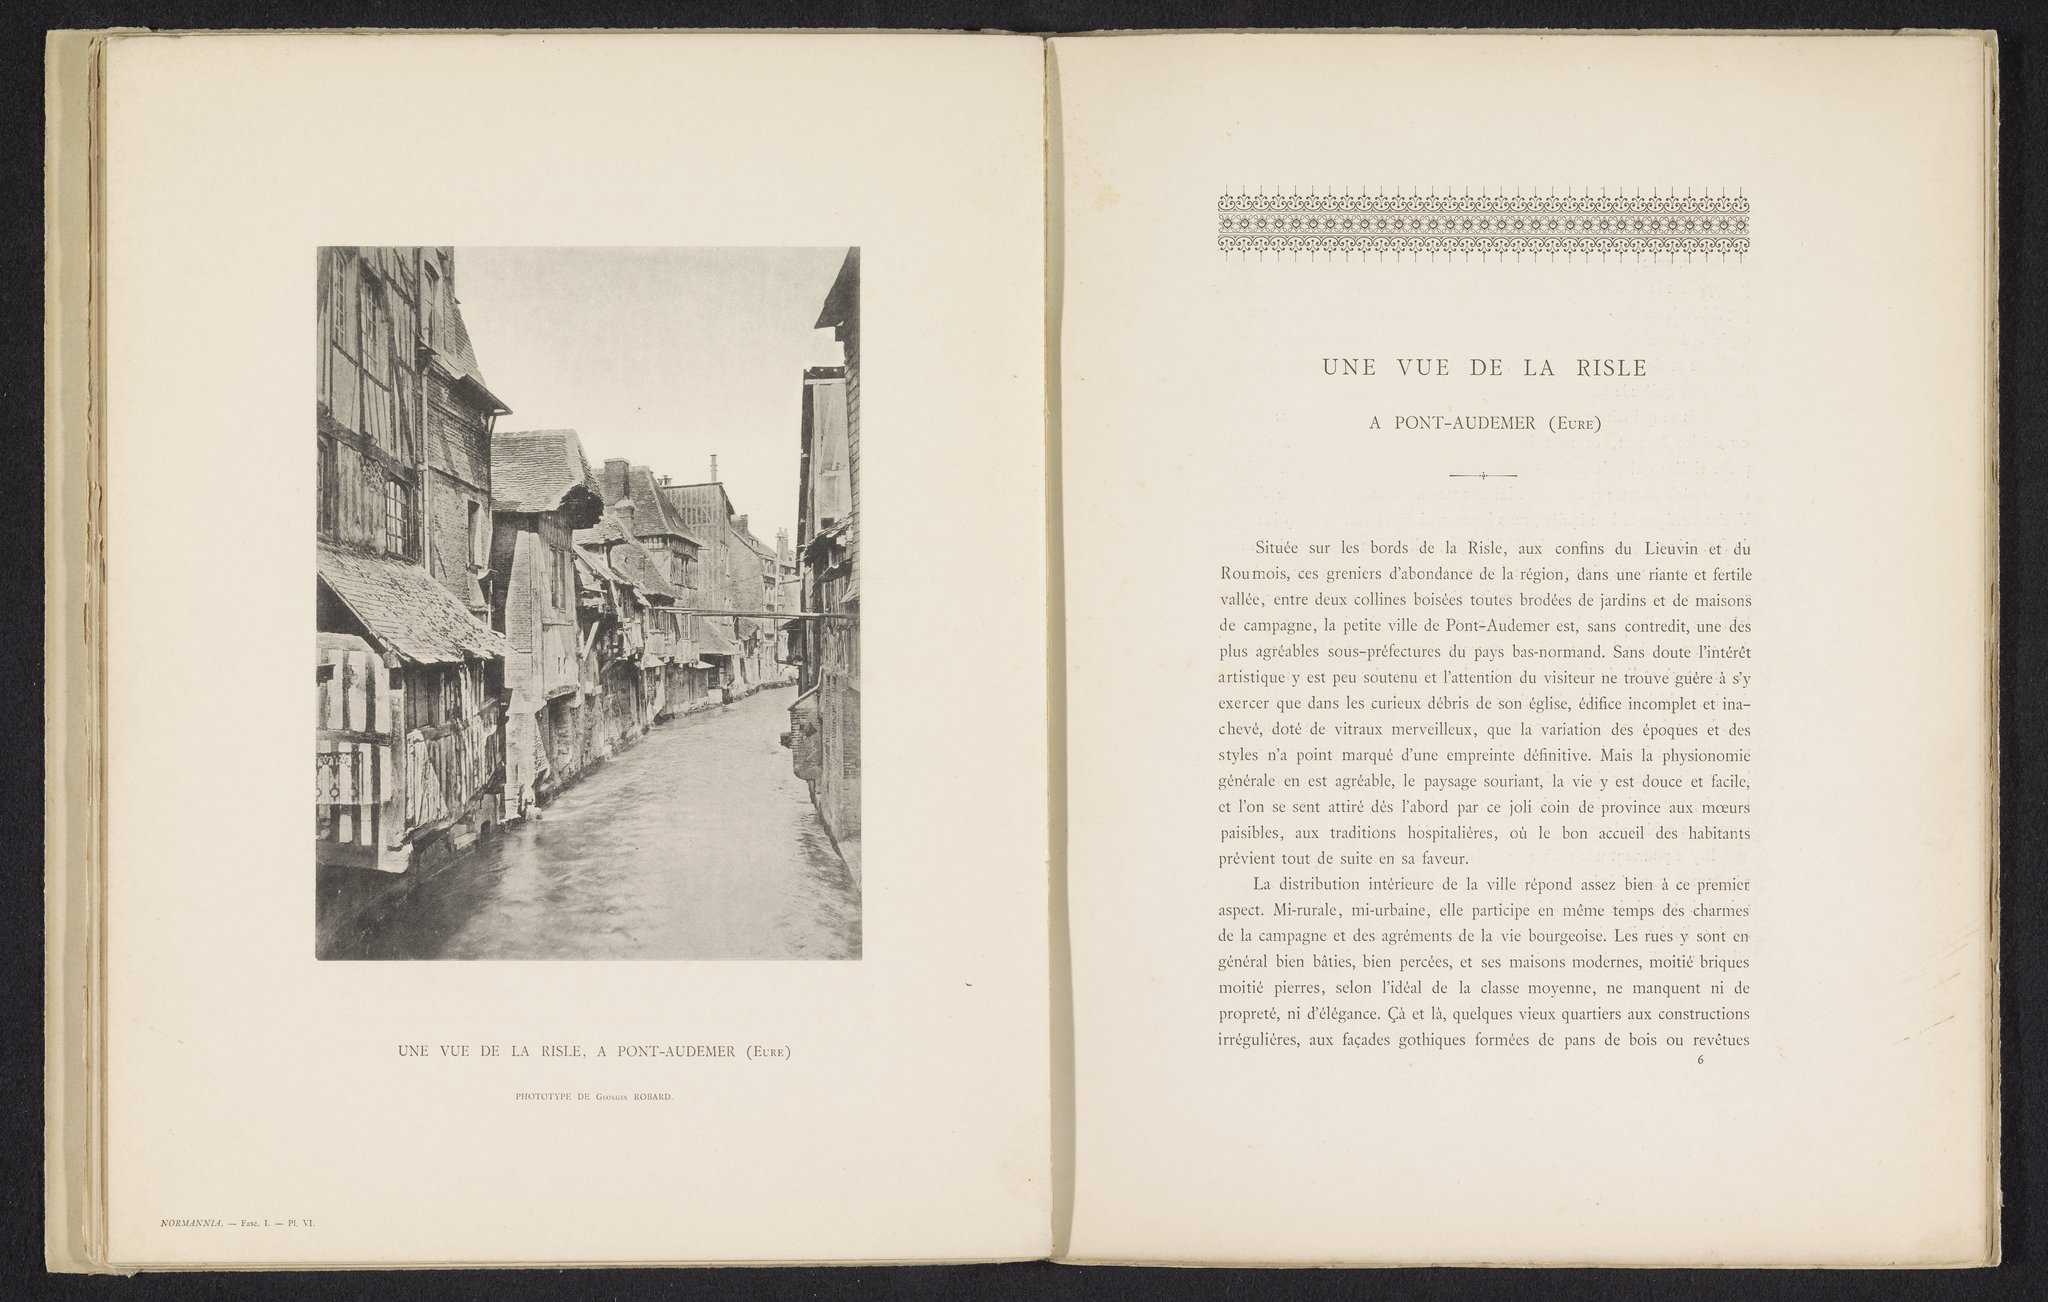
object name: photomechanical print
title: Une vue de la Risle, a Pont-Audemer (Eure)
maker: g. robard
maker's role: fotograaf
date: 1885-1895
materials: paper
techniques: photograph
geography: pont-audemer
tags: river, façade (of house or building)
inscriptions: number: ‘Pl. VI.’